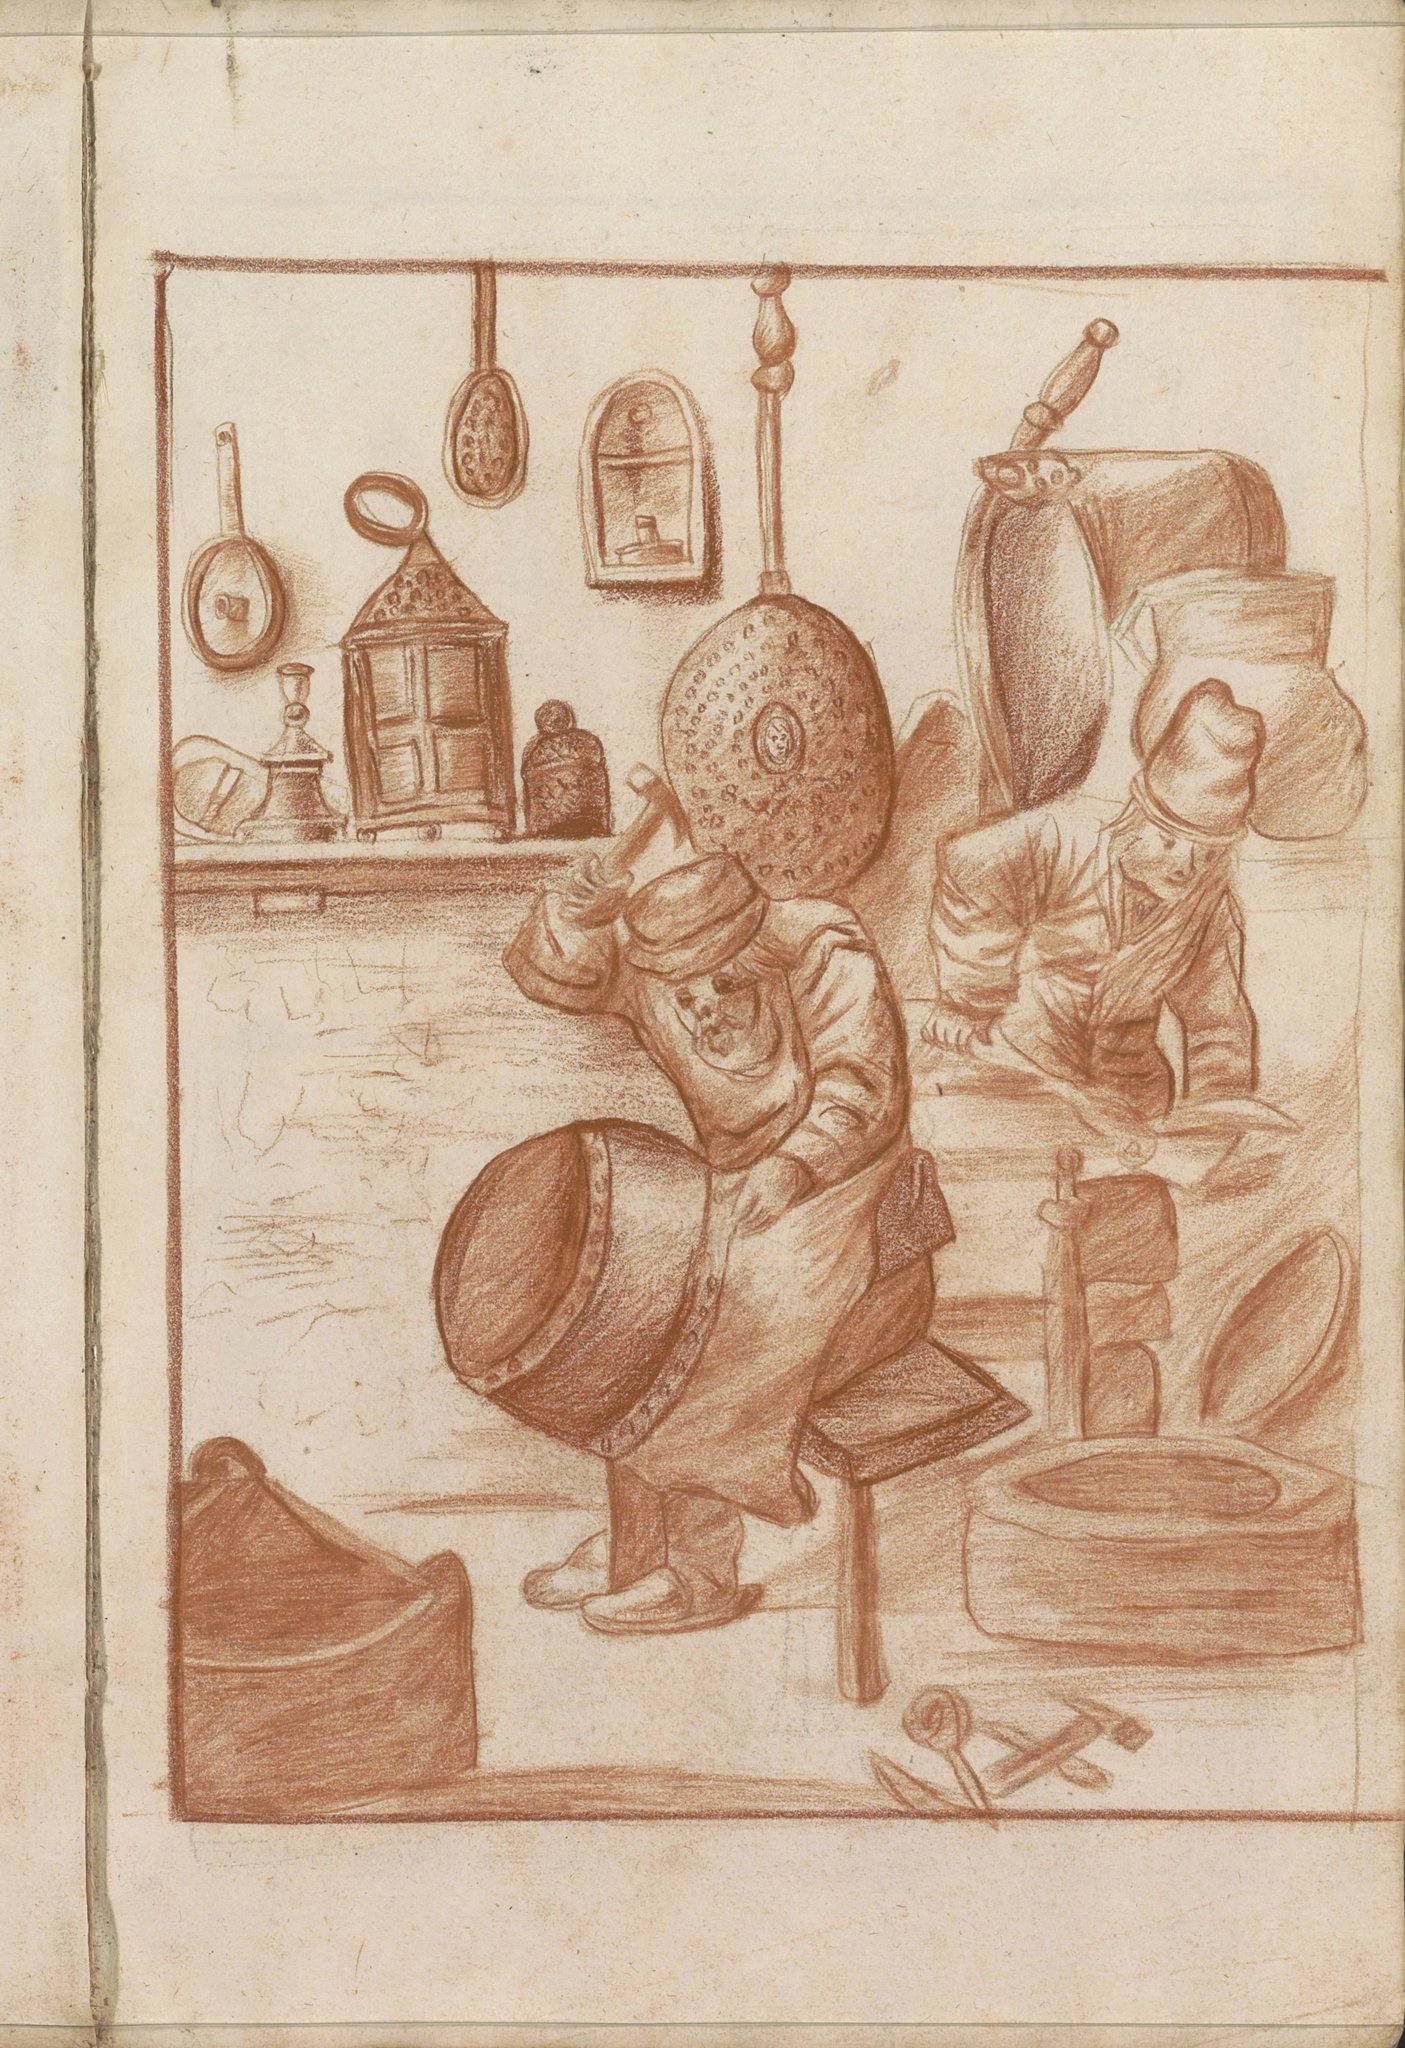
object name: sketchbook leaf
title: Koperslager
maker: hendrick van beaumont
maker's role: draughtsman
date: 1696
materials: chalk, paper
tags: coppersmith, brassworker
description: Blad 61 recto uit een schetsboek met 91 bladen.